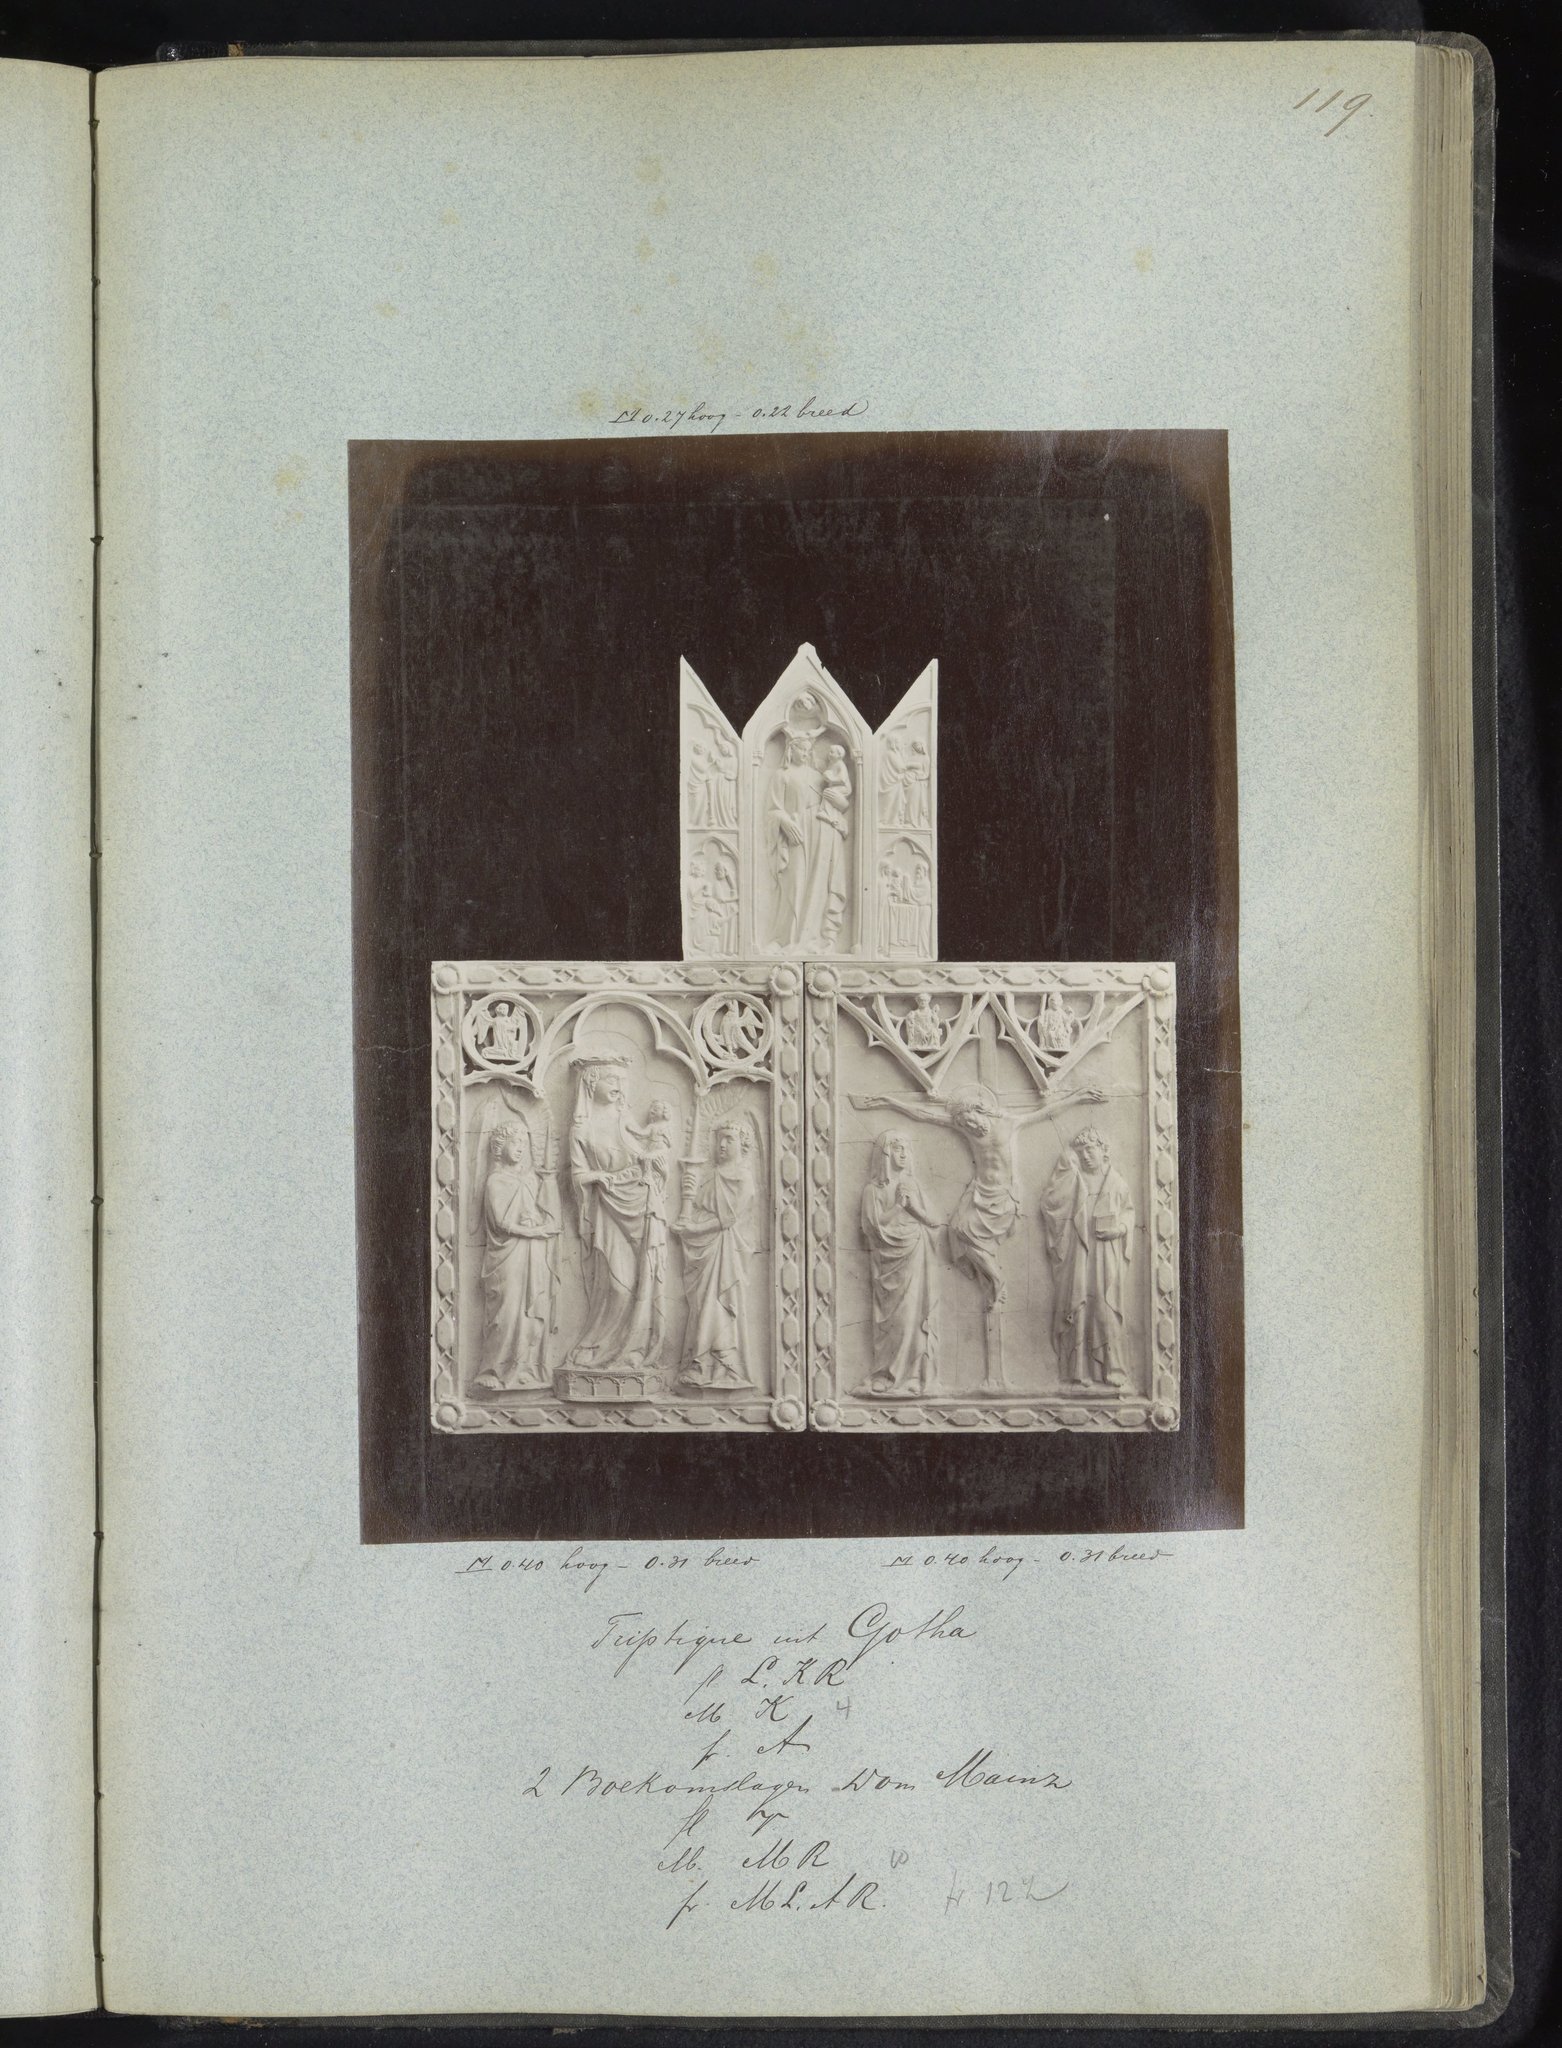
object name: photograph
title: Gipsen afgietsel van een triptiek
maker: Anonymous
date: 1875-1900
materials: paper, photographic support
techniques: albumen print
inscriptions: annotation: ‘M 0.27 hoog - M 0.22 breed / M 0.40 hoog - 0.31 breed M 0.40 hoog - 0.31 breed’, annotation: ‘Triptique uit Gotha’, annotation, annotation: ‘2 Boekomslagen Dom Mainz’